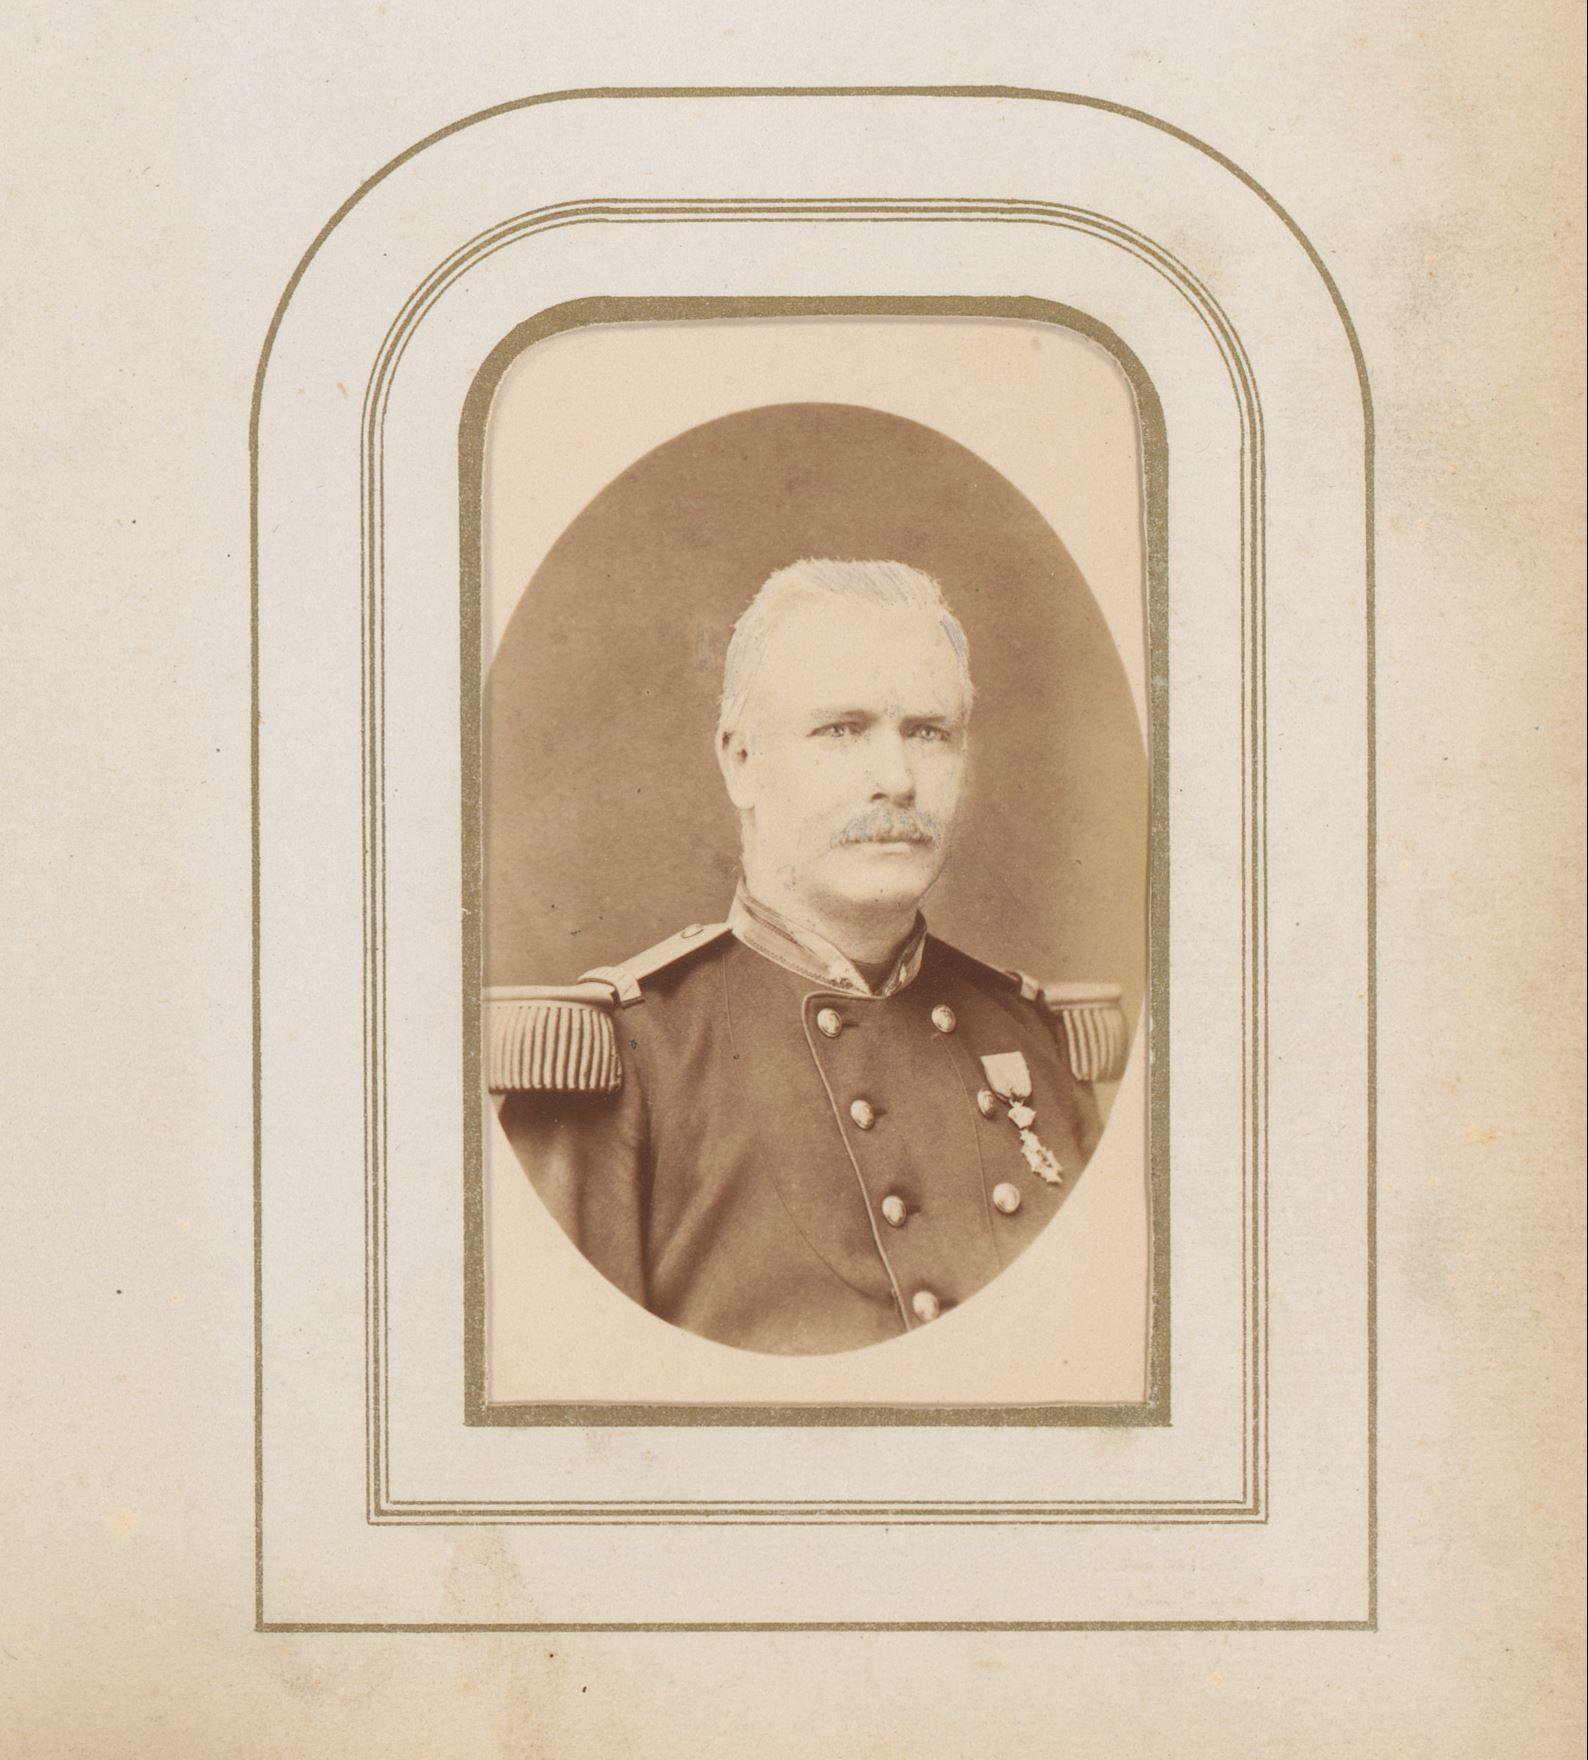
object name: photograph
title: Portret van een man met snor in uniform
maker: edouard josz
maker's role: fotograaf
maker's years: 1845-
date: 1877-1880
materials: cardboard, photographic support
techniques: albumen print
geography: bergen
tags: moustache, historical persons, (military) uniforms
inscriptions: inscription: ‘Photographie E. Josz/ Médaille d'argent/ 35, rue de la Chaussée, 35/ Mons’